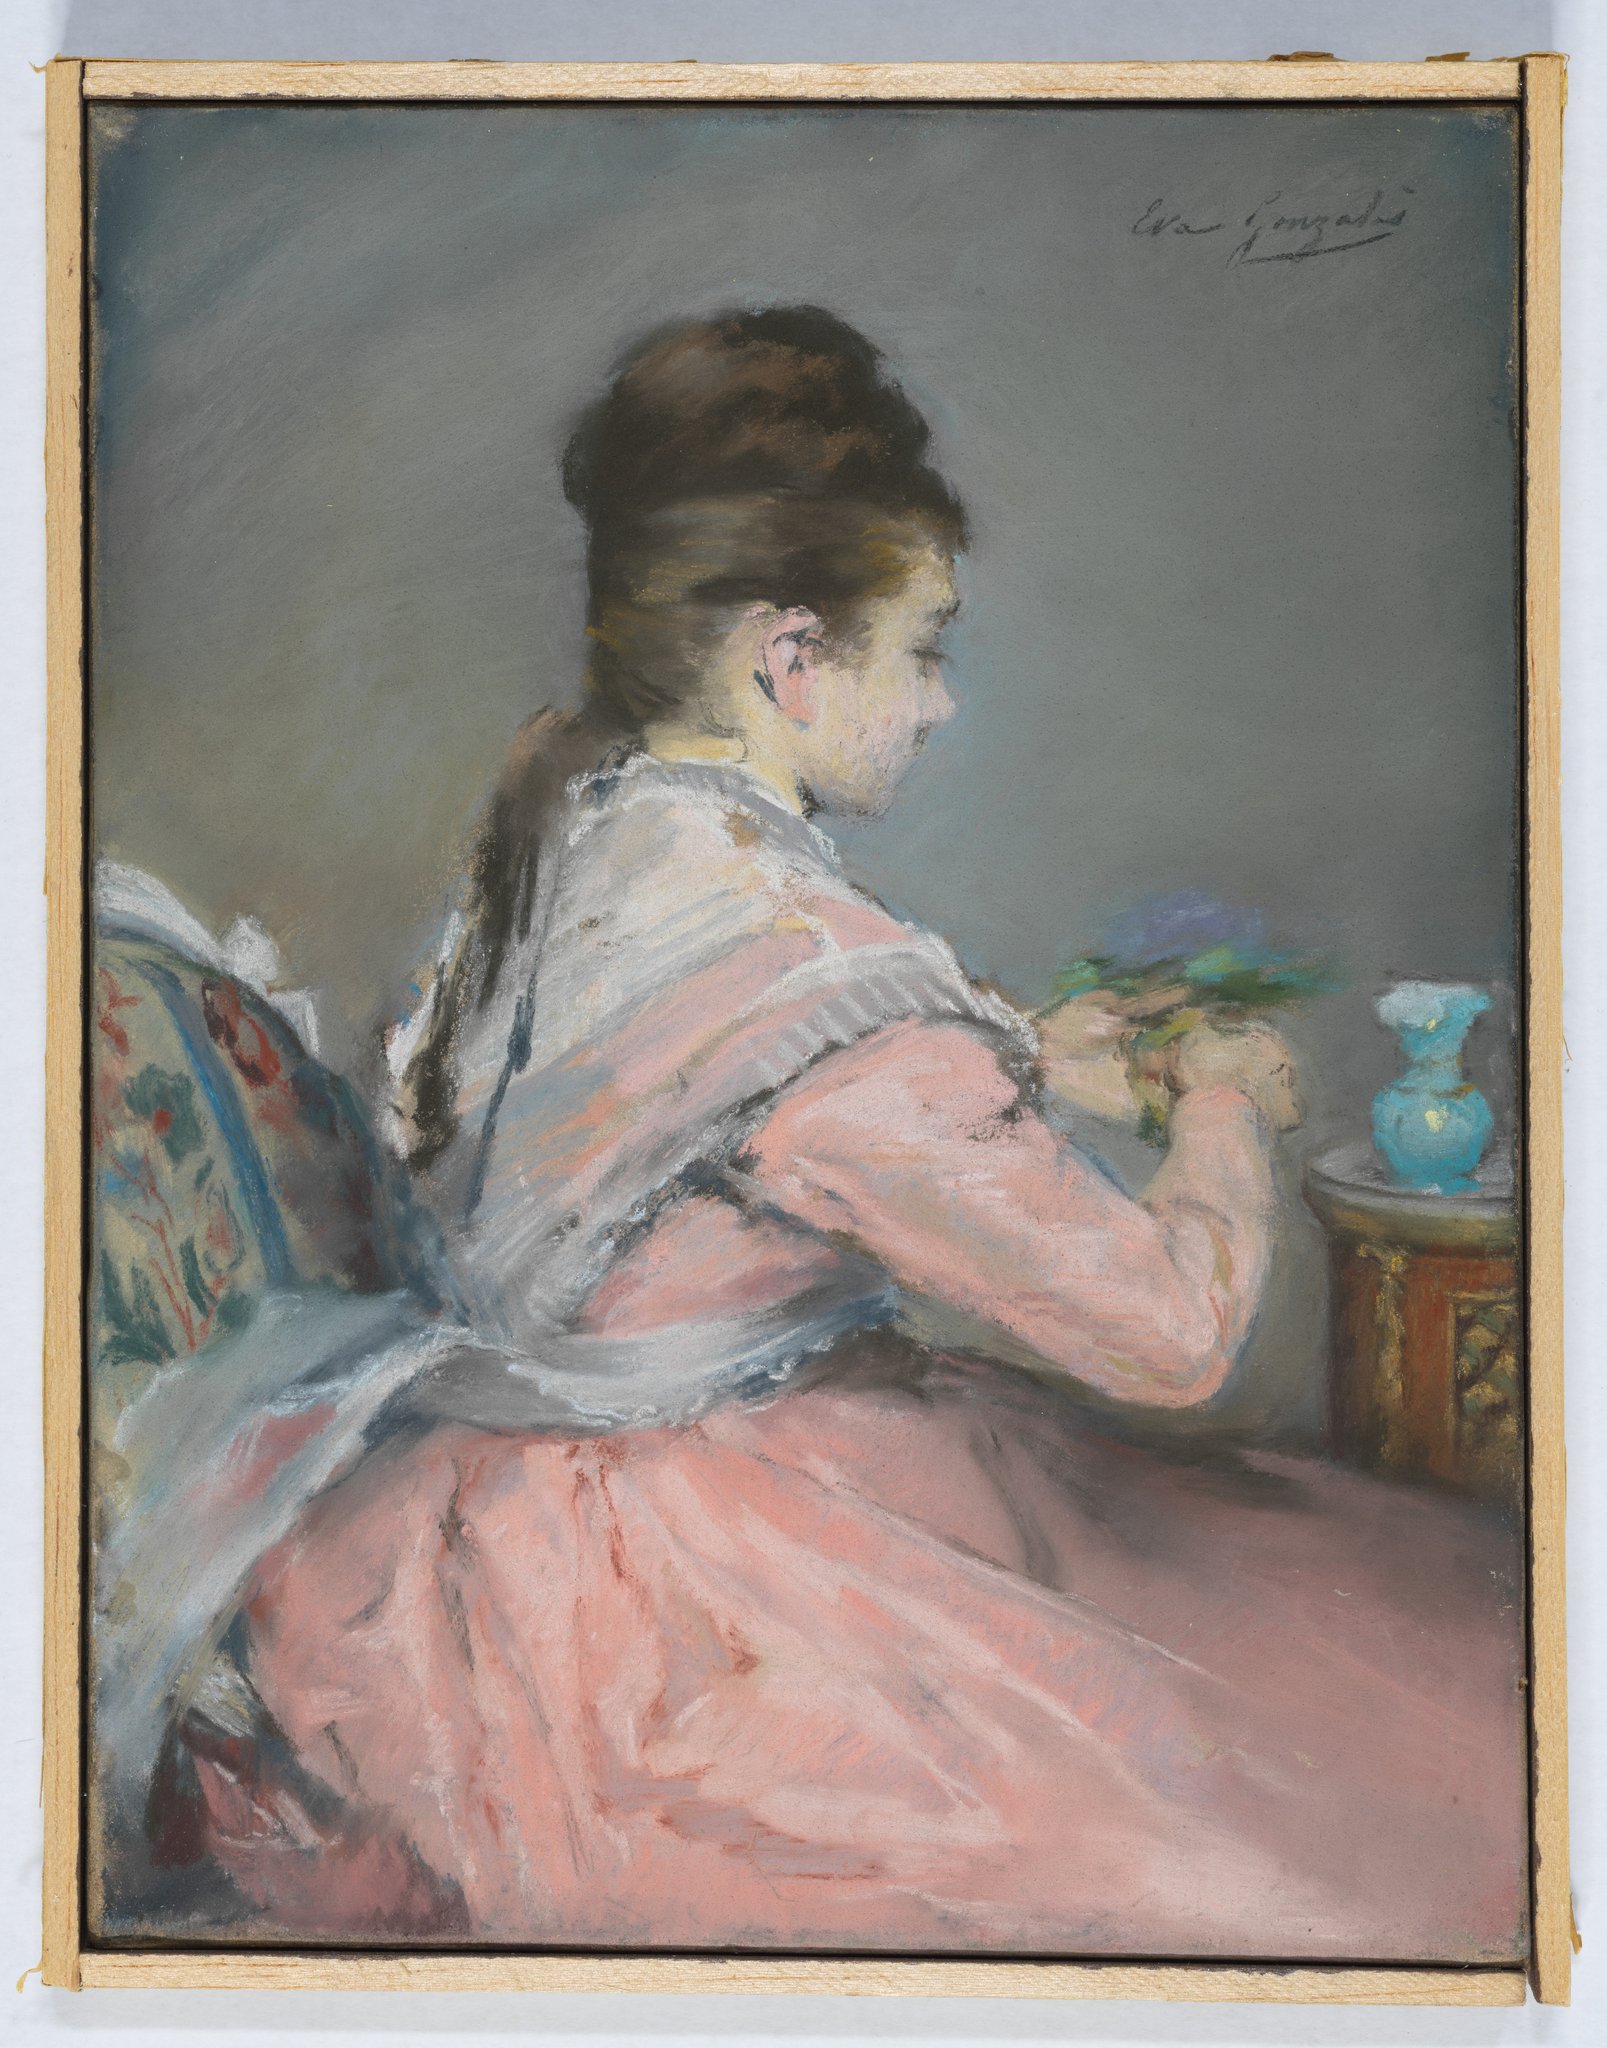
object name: drawing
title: The Bouquet of Violets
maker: eva gonzalès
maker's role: artist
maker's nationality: french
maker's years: 1847-1883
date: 1877-1878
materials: pastel, paper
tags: women,violets